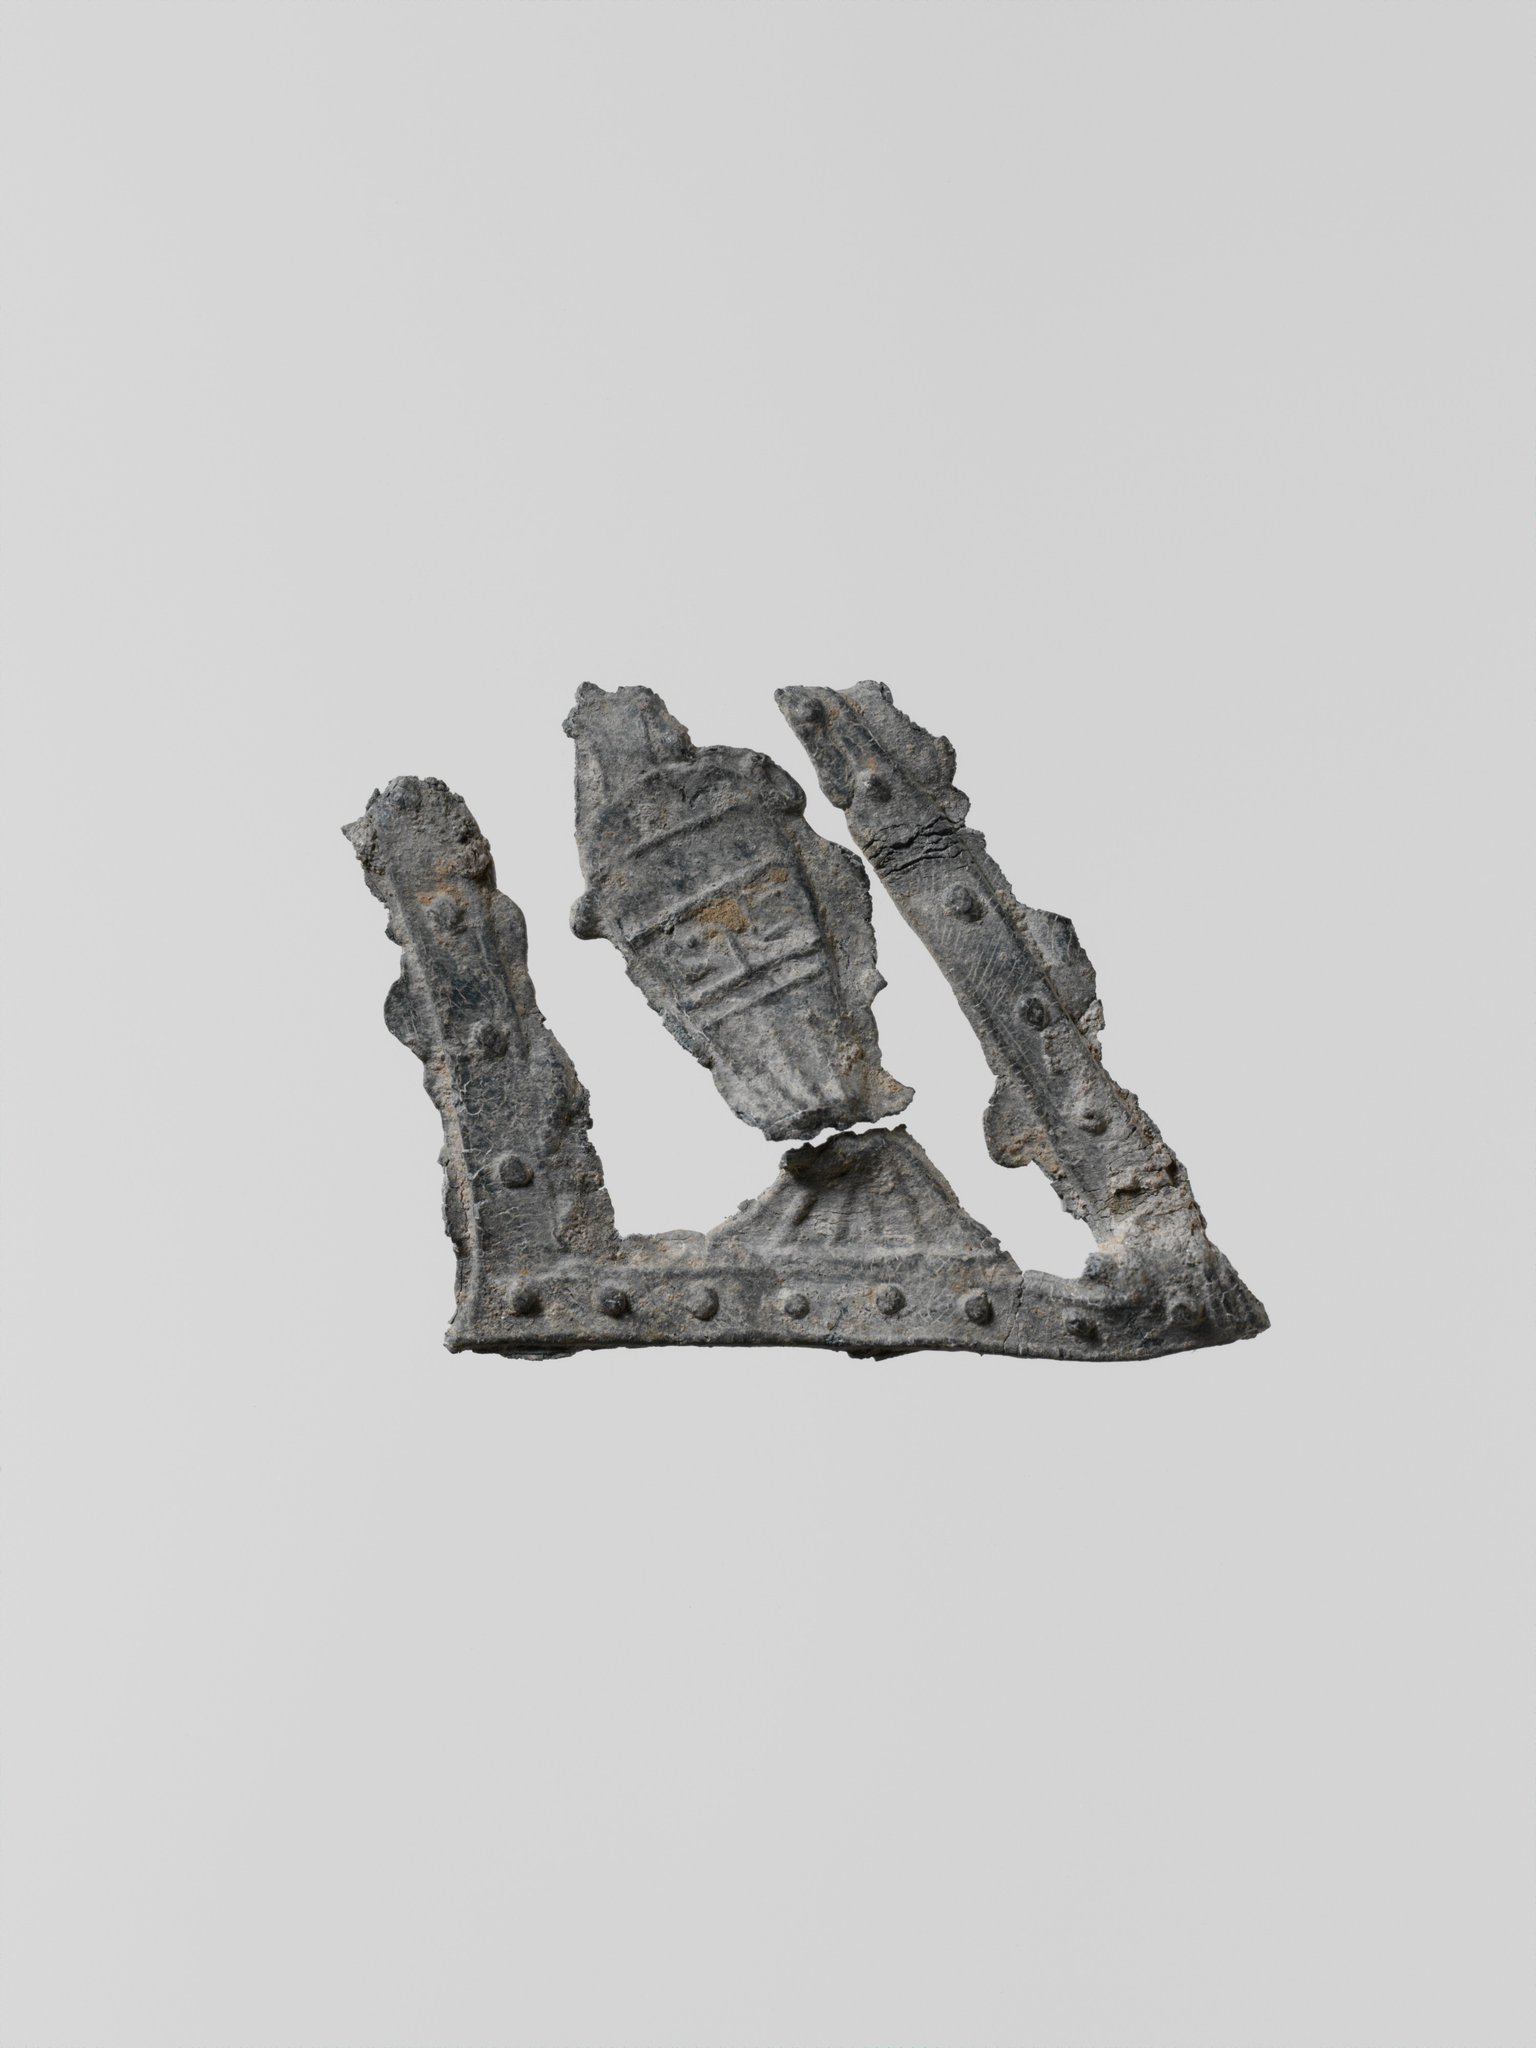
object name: ornament, 14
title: Ornaments, 14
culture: greek, laconian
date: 7000-30 BCE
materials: lead